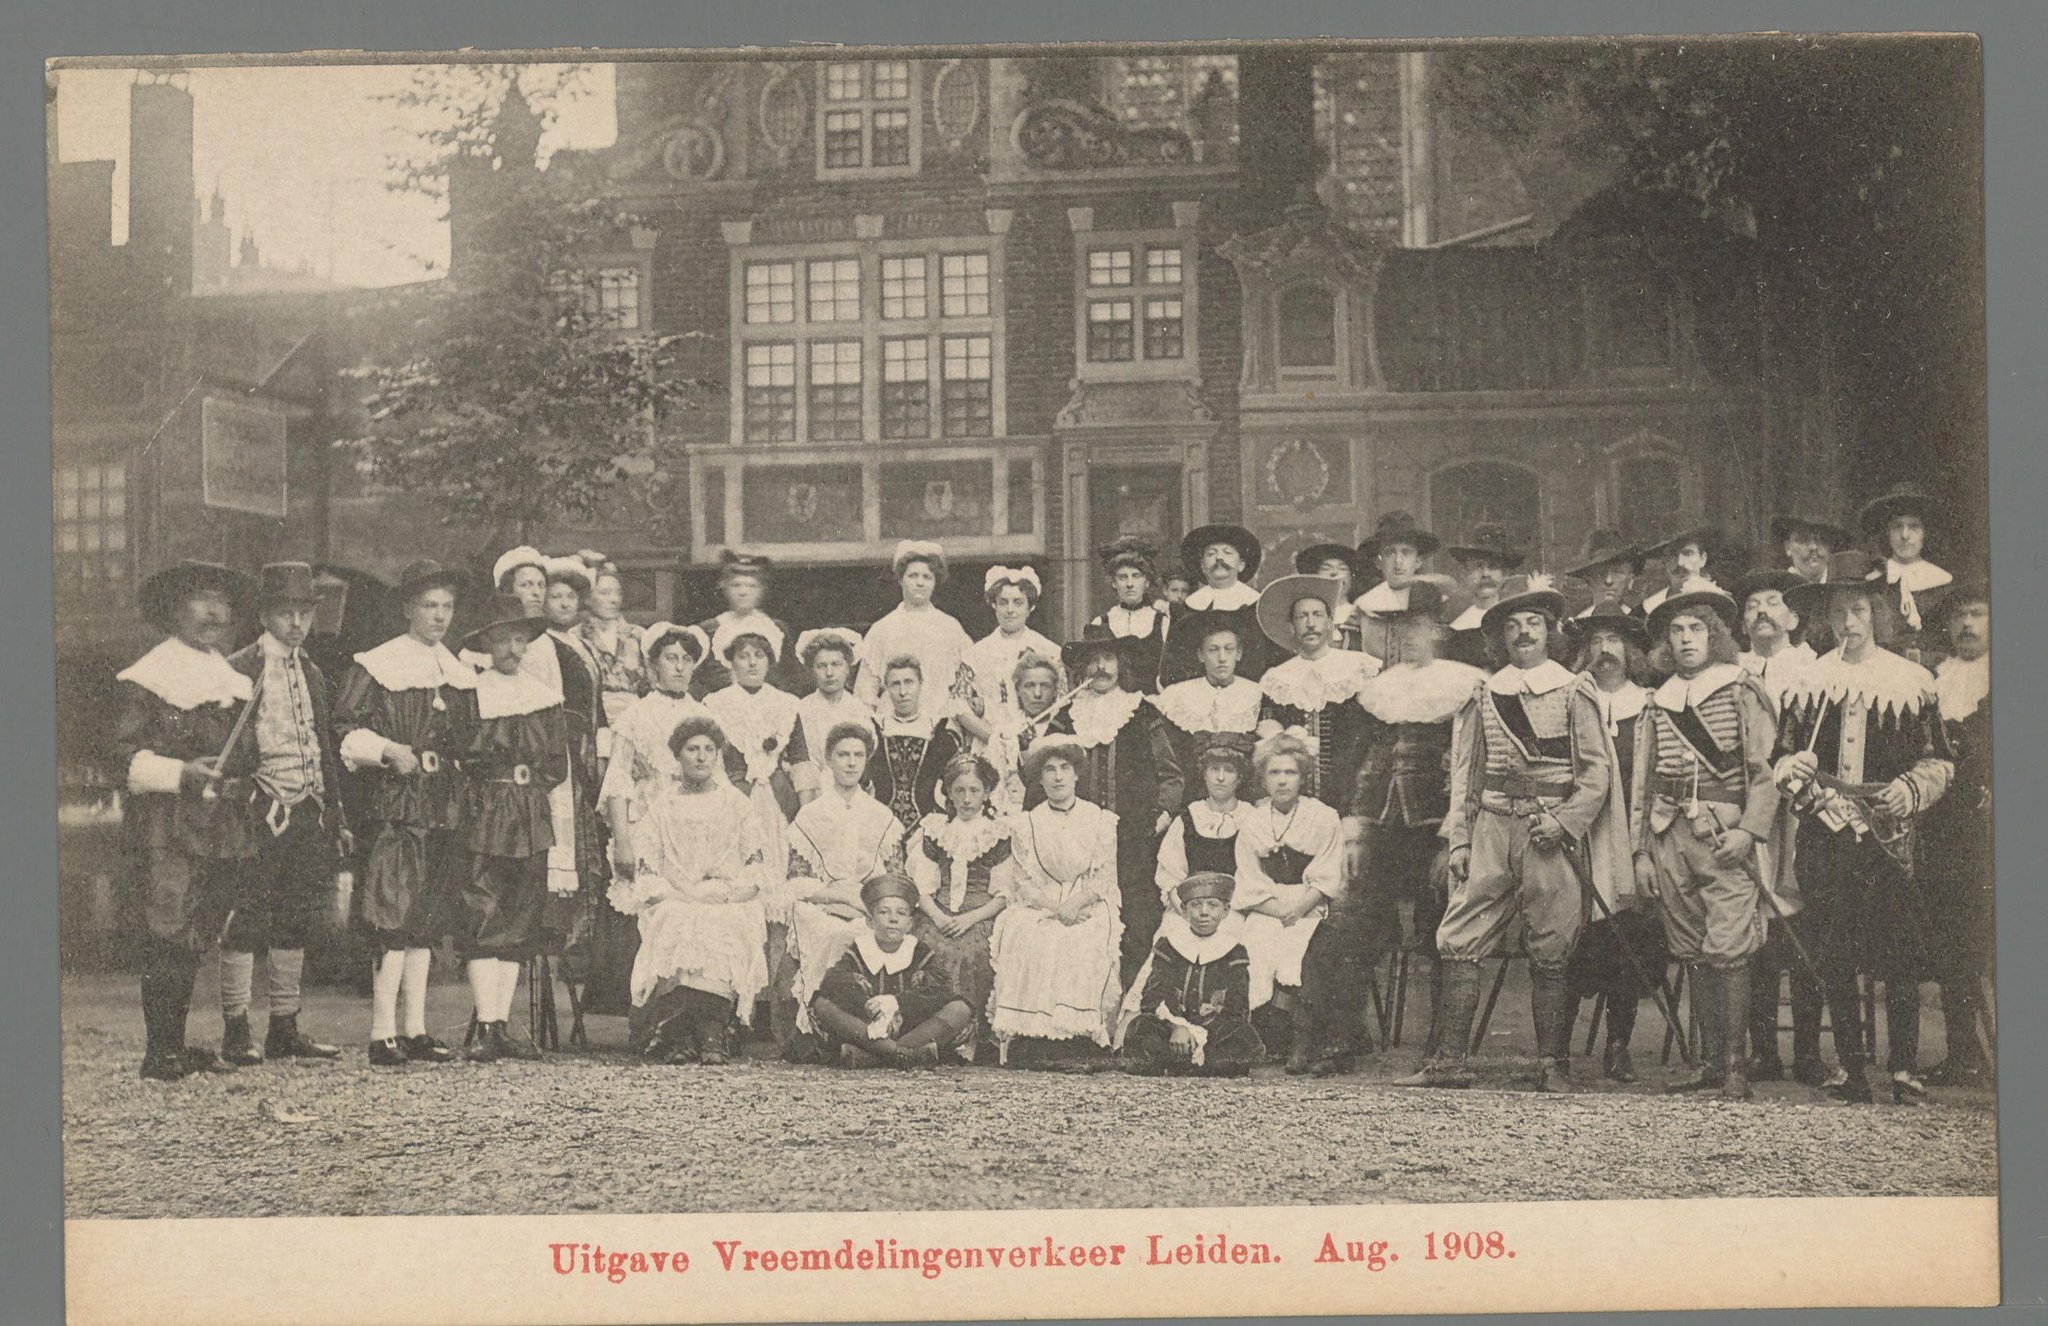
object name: photomechanical print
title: Groepsportret van mensen in kostuum tijdens de Oud-Hollandse feesten te Leiden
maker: Anonymous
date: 1908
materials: cardboard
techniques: photograph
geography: leiden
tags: dress-up party, festivities, anonymous historical persons portrayed in a group, in a group-portrait, leiden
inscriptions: date